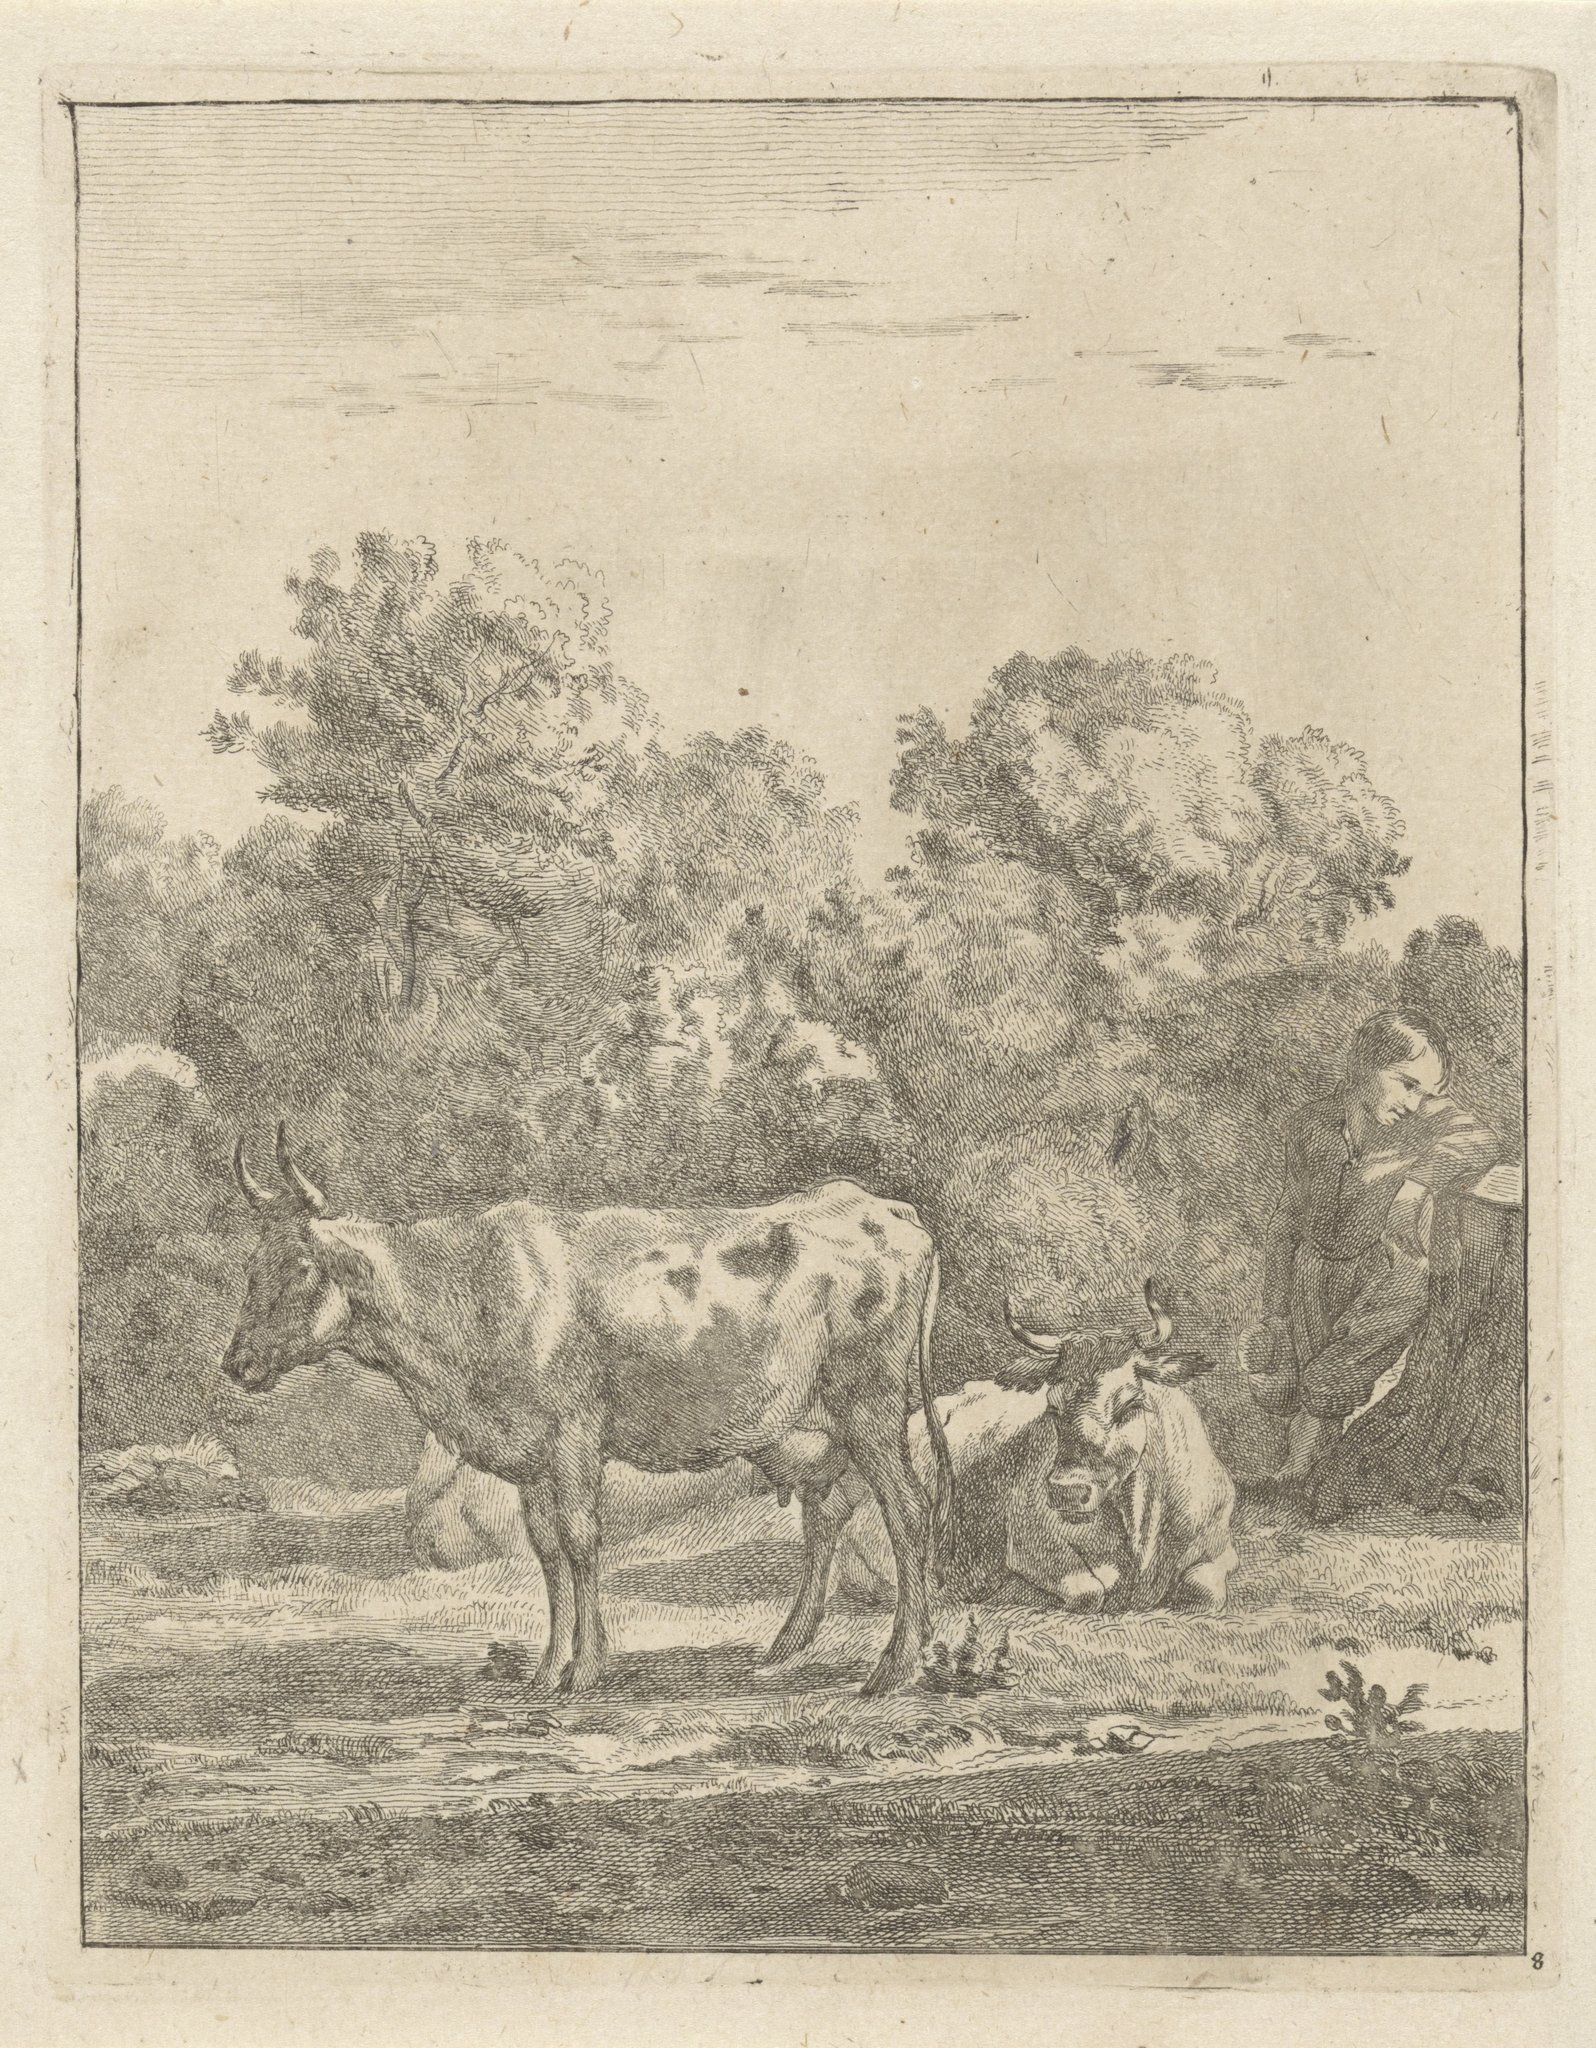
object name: print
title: Diversa Animalia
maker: Anonymous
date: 1643-1692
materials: paper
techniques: engraving, etching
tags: cow, herding, herdsman, herdswoman, shepherd, shepherdess, cowherd, etc.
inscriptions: collector's mark: Lugt 2228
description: In een door bomen omgeven weide staan een jongen en twee koeien. De jongen leunt op de stam van een gekapte boom.